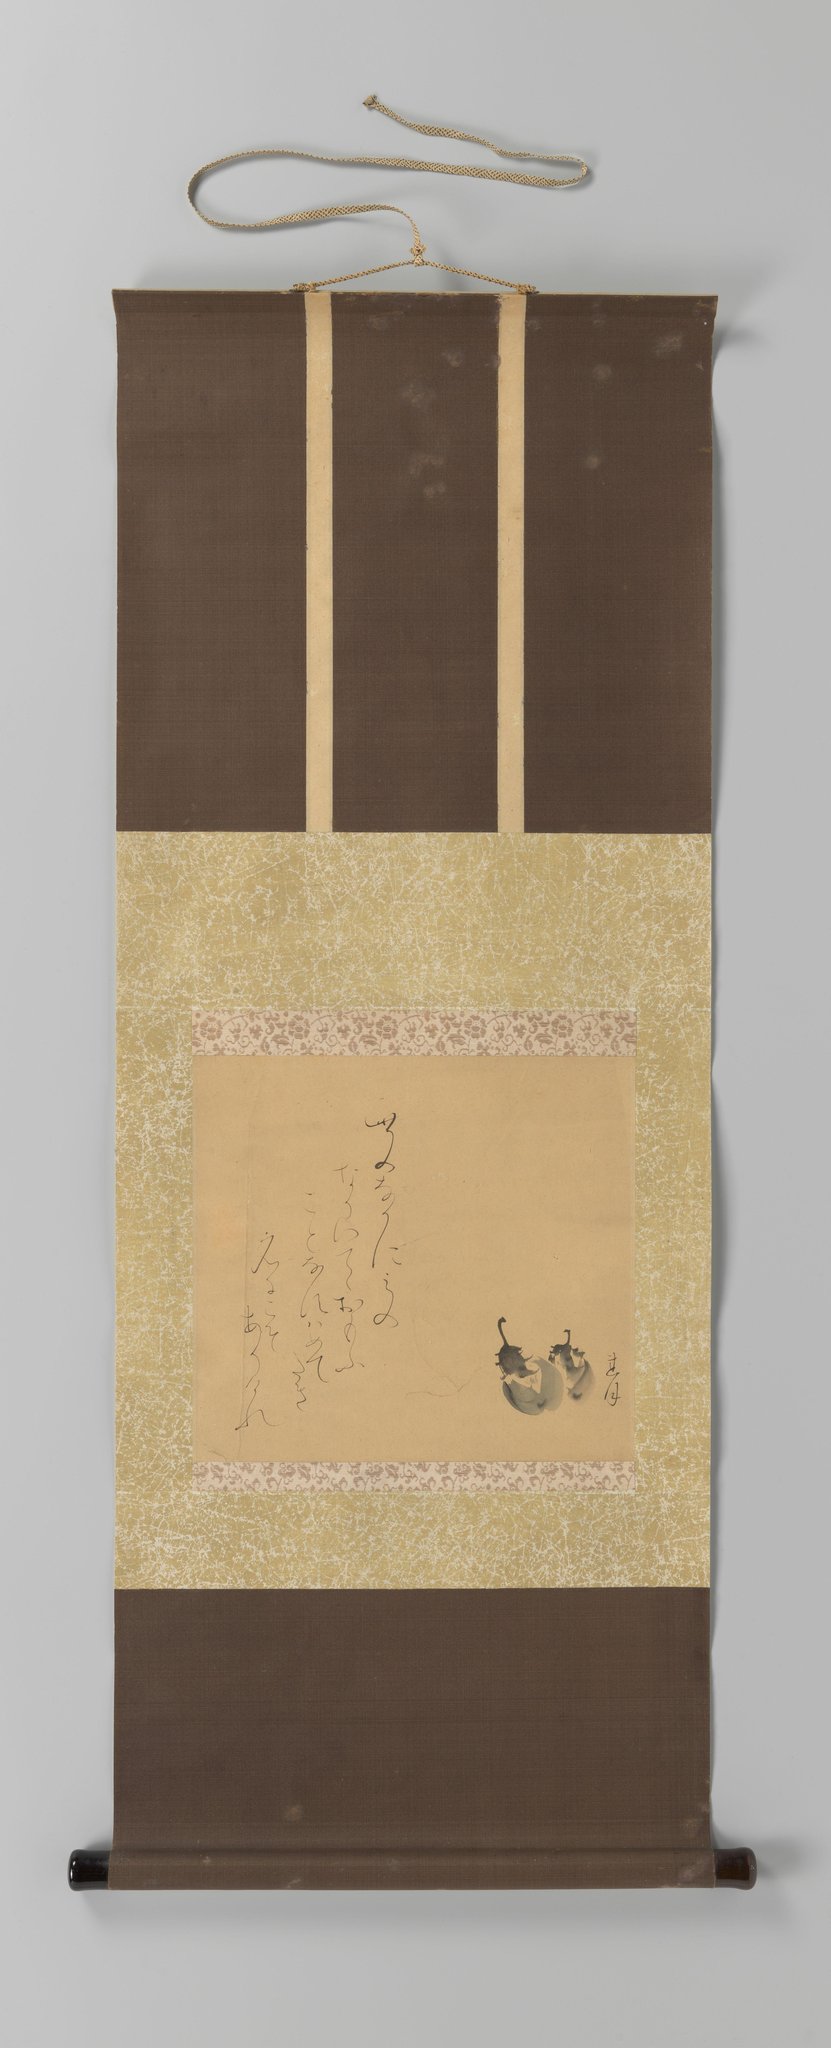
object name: hanging scroll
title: Eggplants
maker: ōtagaki rengetsu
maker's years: 1791-1875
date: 1850-1855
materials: ink, paint, paper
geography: japan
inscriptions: signature: ‘蓮月’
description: The Bhuddist monk-painter Rengetsu had a characteristic, cursive form of writing. With a clever play on words, her poem reflects on the fruits of life and extols ‘eggplants’ and the triumph of ‘achieving a goal.’ The two words share the same pronunciation nasu.